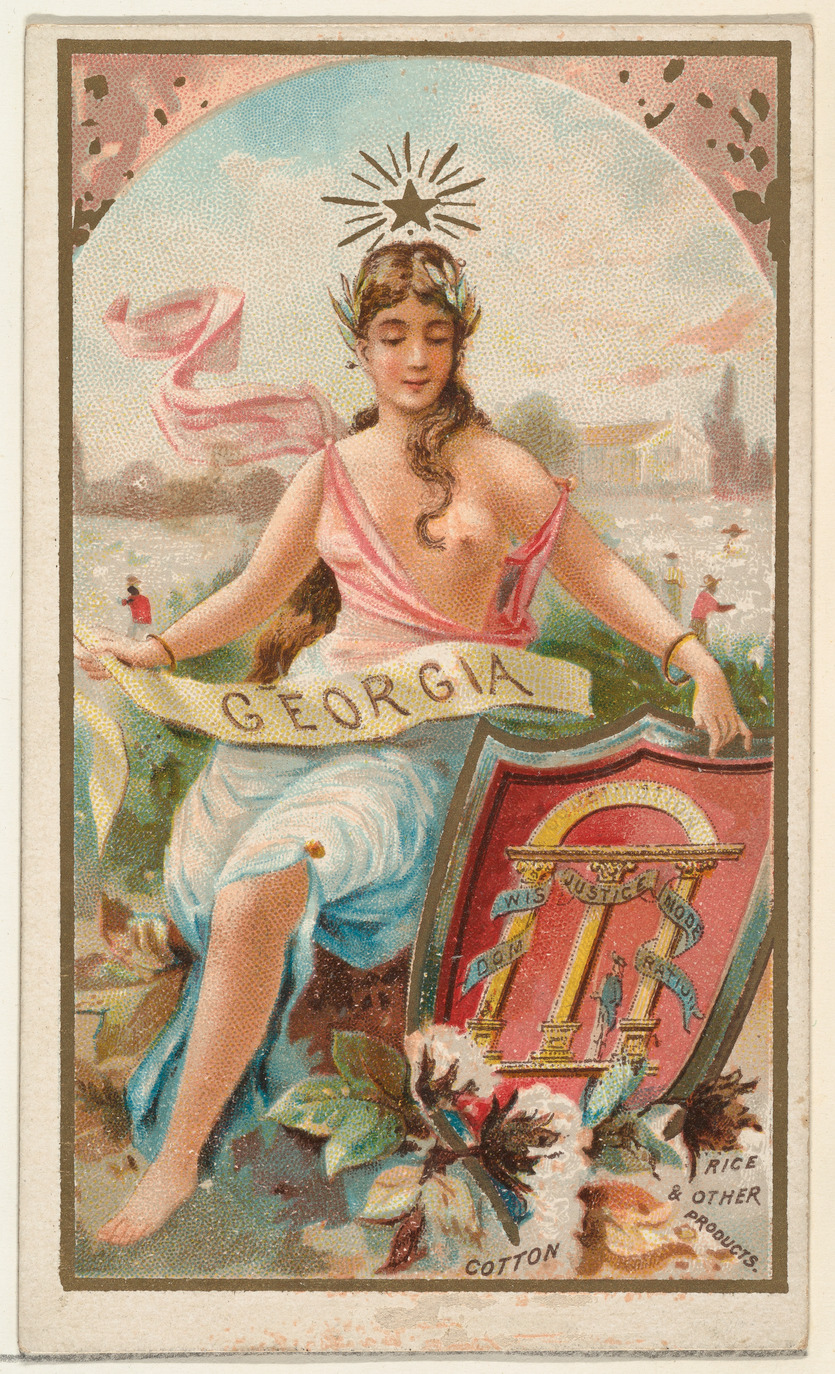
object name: print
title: Georgia, from the Industries of States series (N117) issued by Duke Sons & Co. to promote Honest Long Cut Tobacco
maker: w. duke, sons & co.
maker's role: publisher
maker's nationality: american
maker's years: 1870-1920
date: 1889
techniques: color lithograph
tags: shields,female nudes